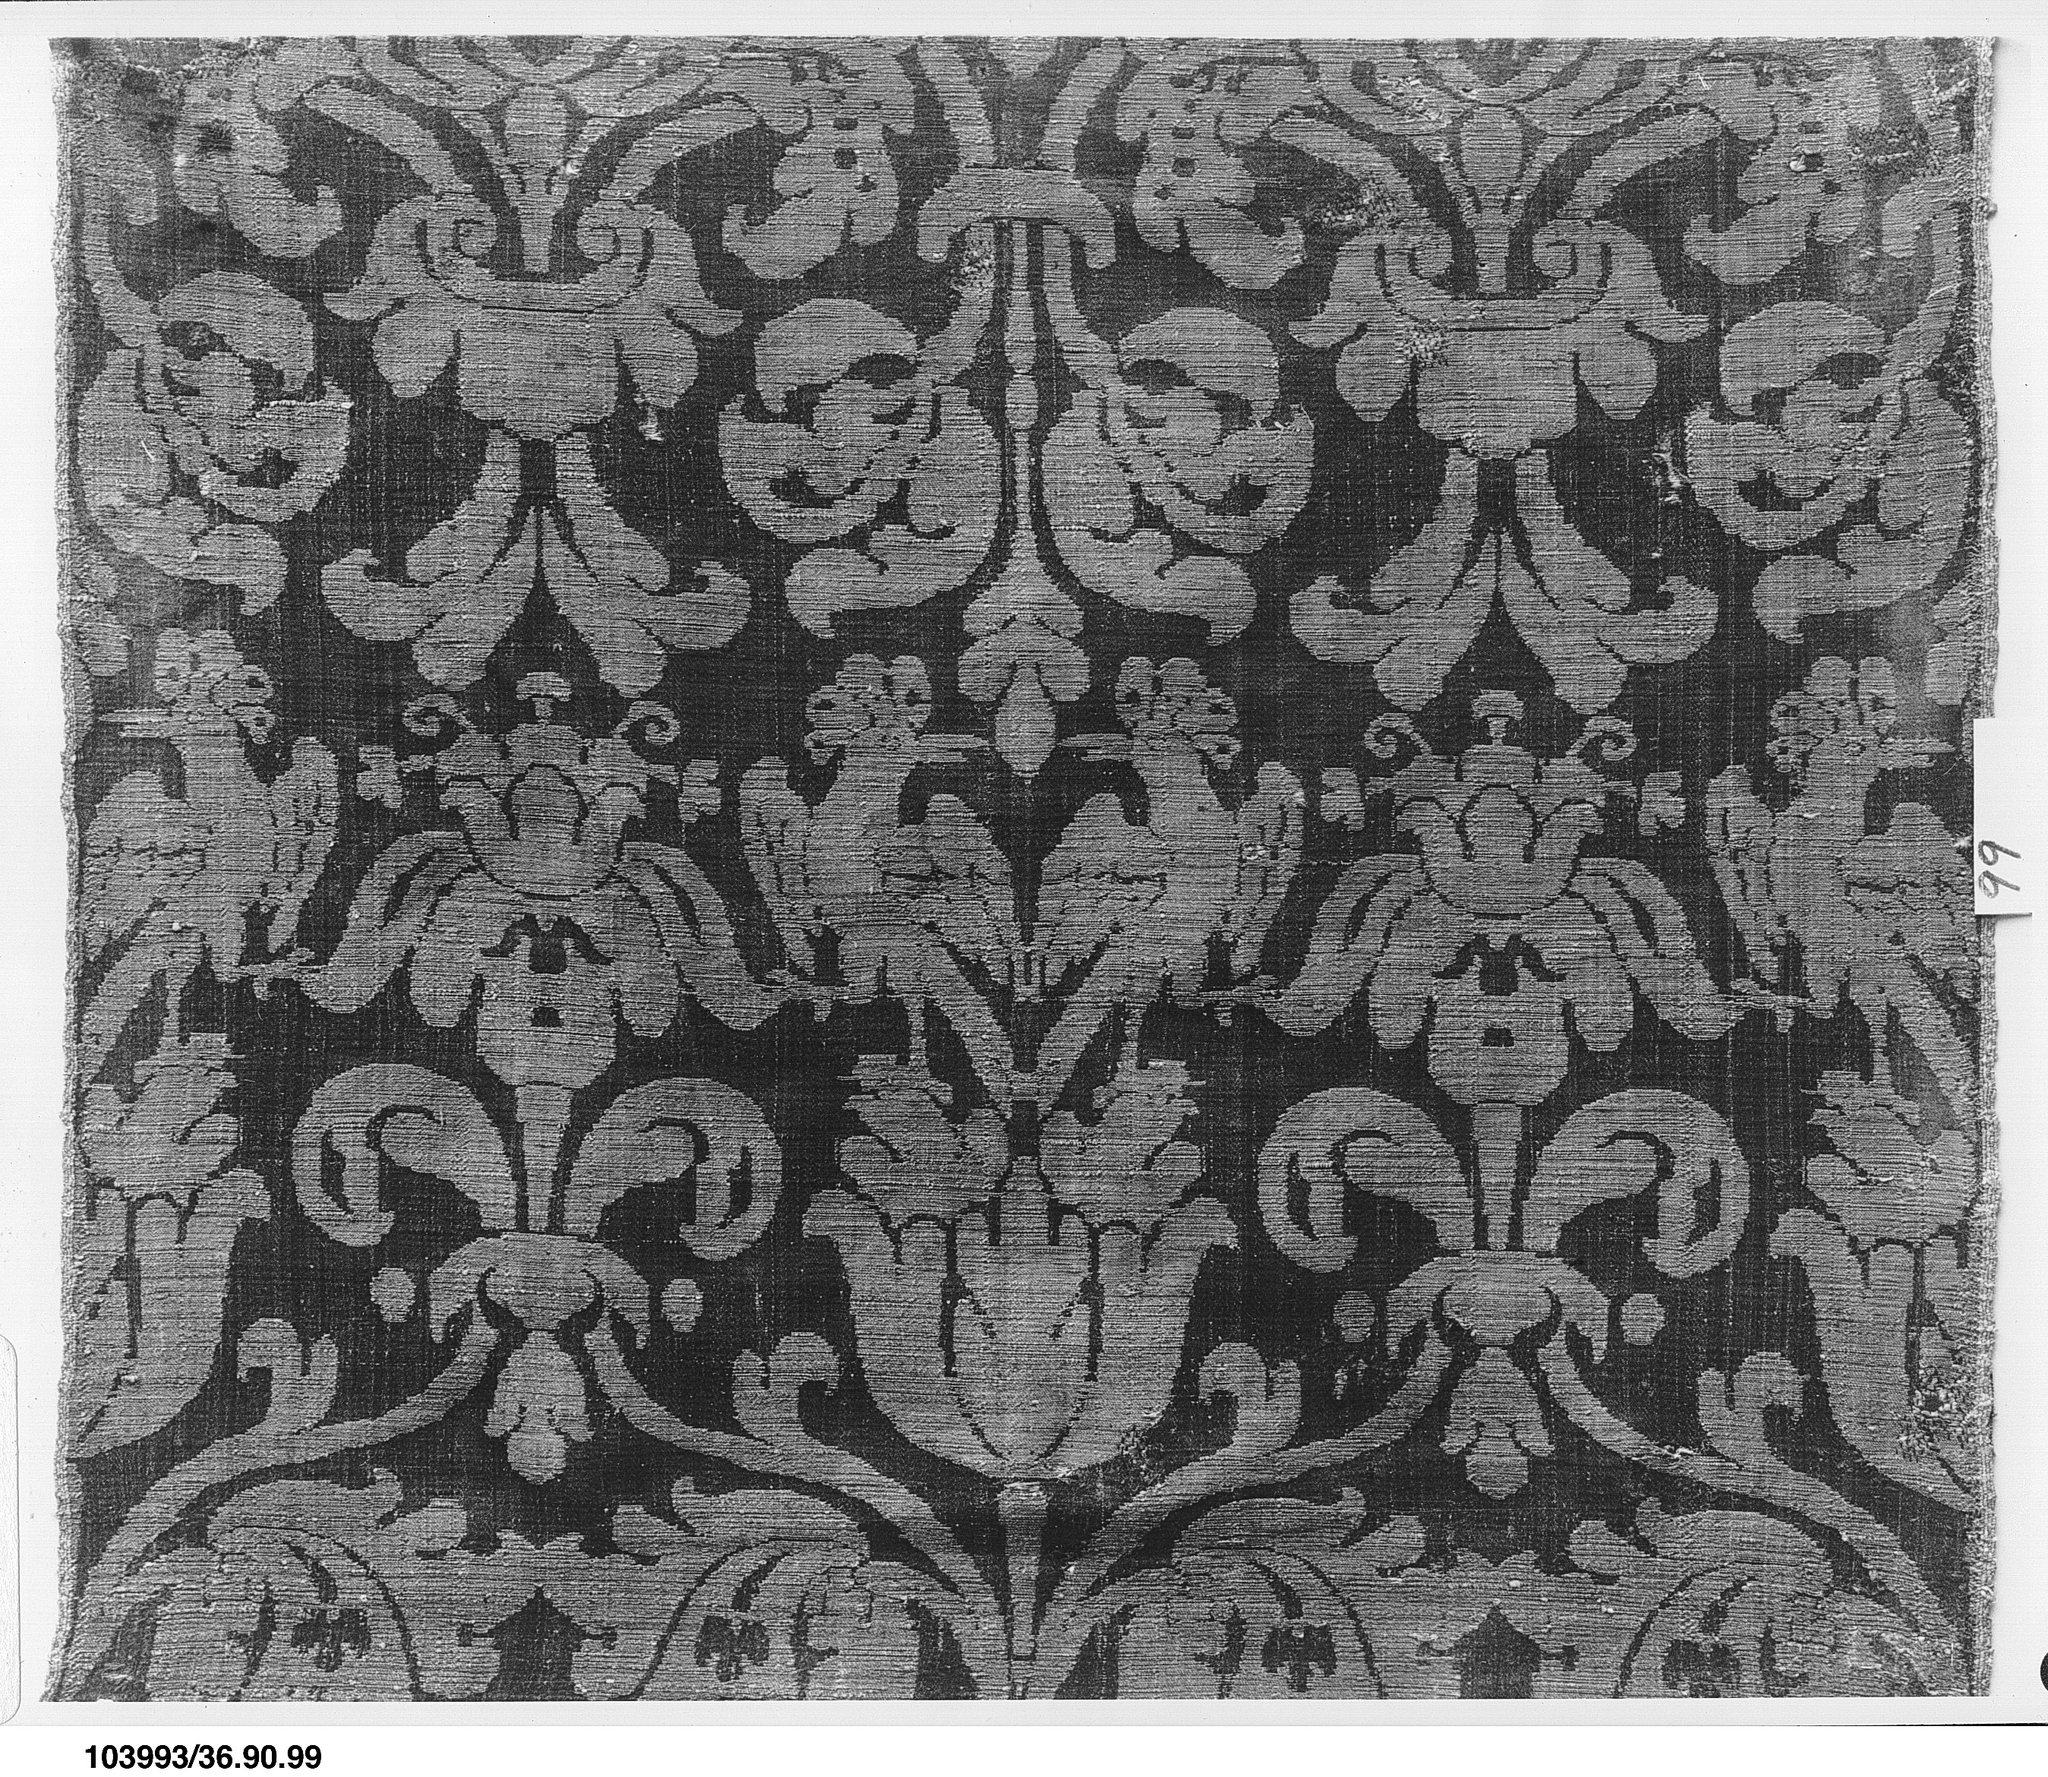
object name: piece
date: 1601-1700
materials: silk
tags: birds,flowers